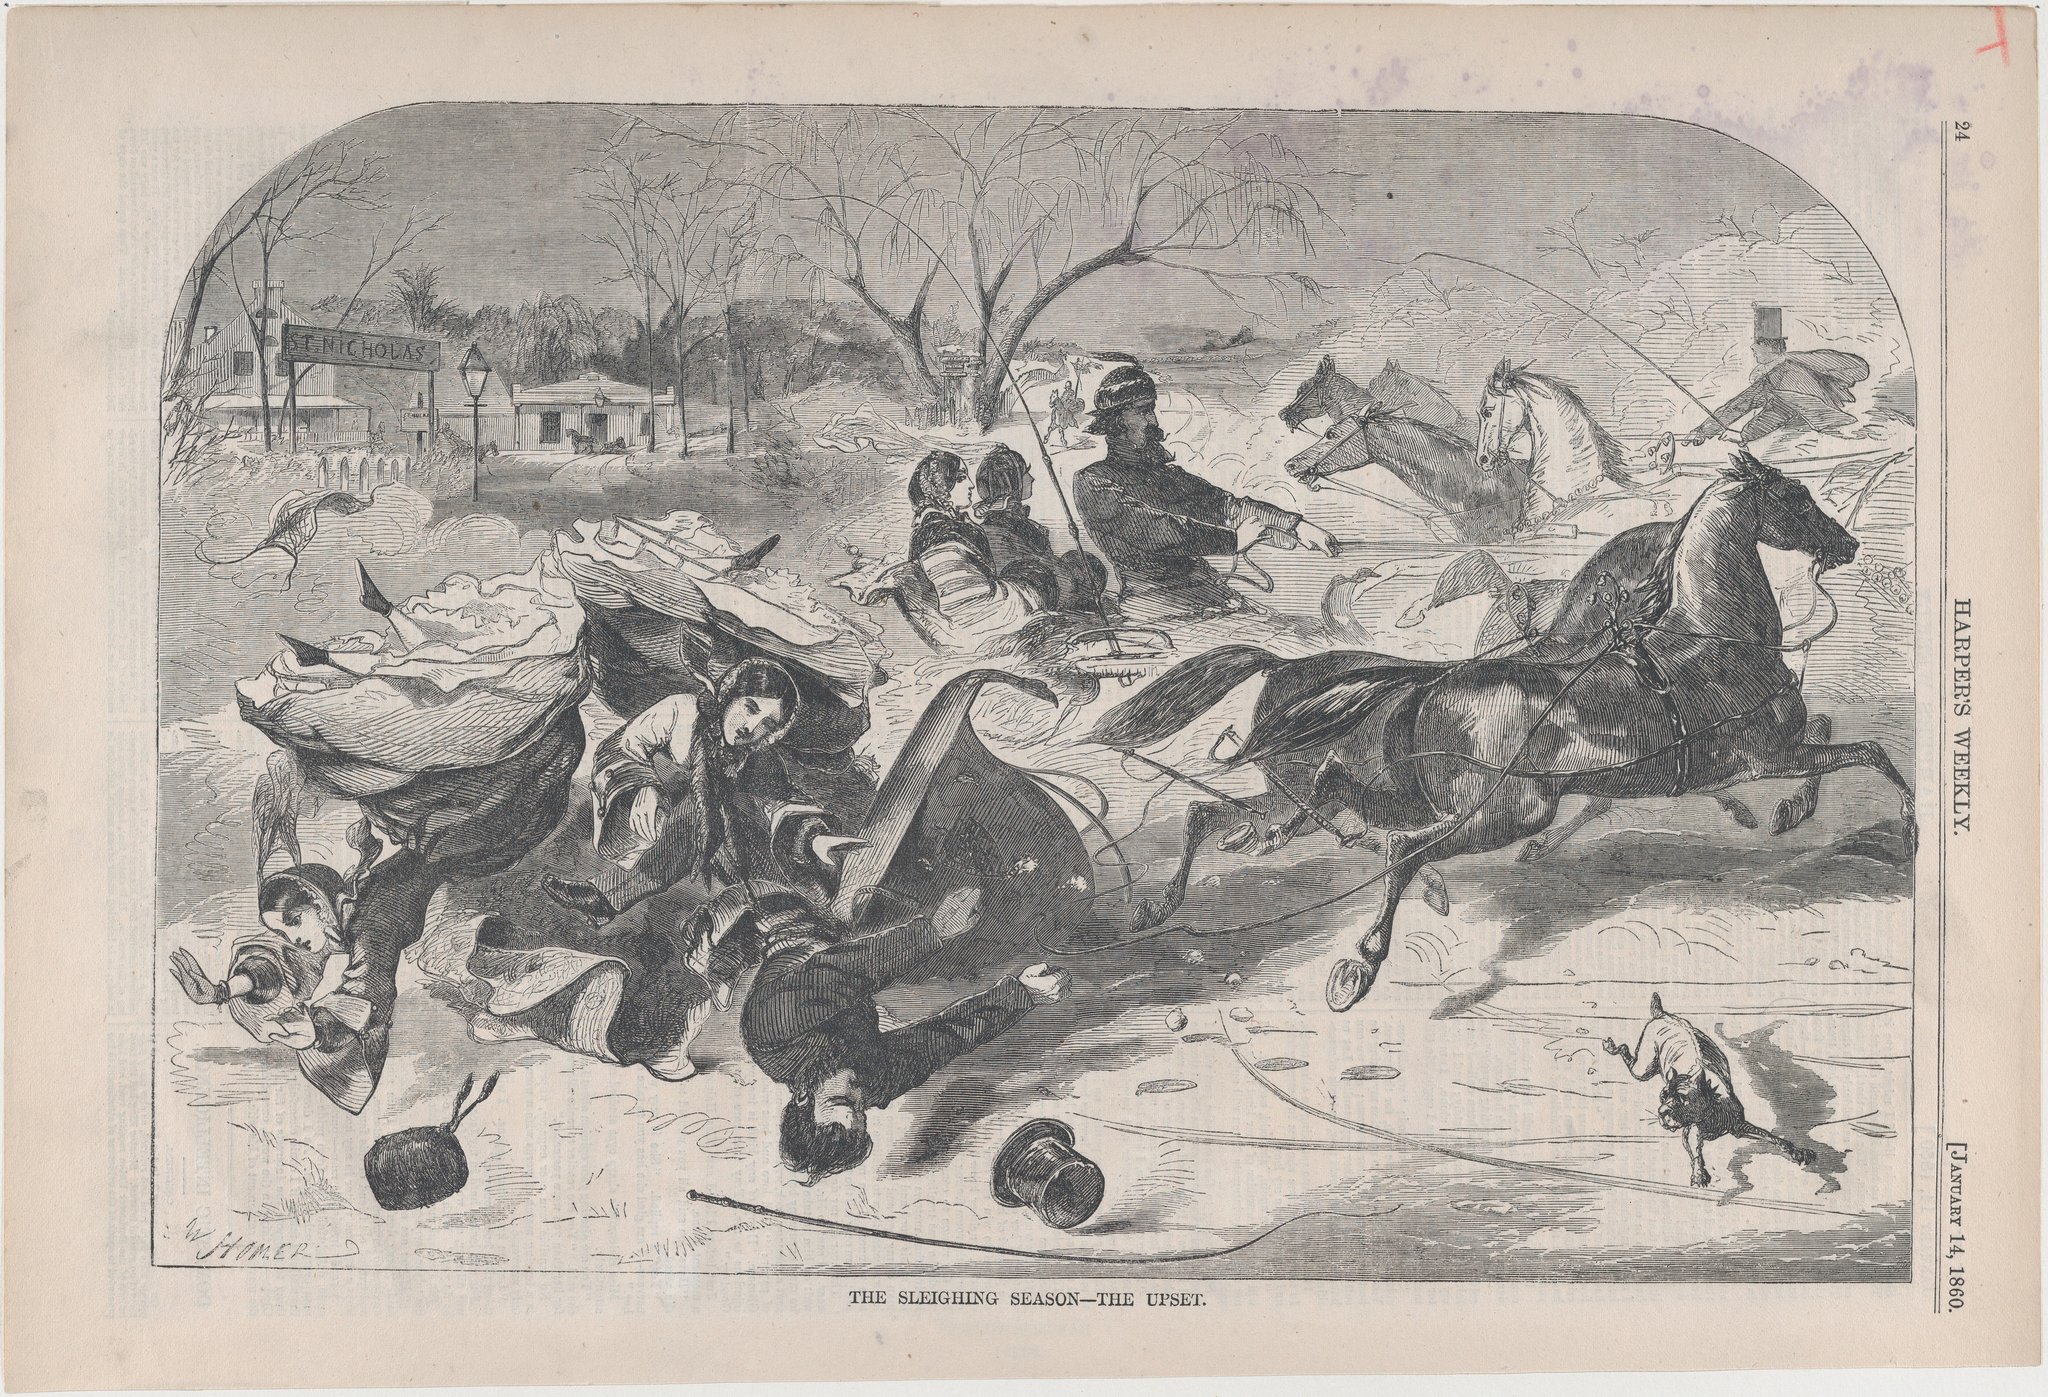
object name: print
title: The Sleighing Season – The Upset (from "Harper's Weekly," Vol. IV)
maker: winslow homer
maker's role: artist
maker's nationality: american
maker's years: 1836-1910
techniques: engraving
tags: men,women,horses